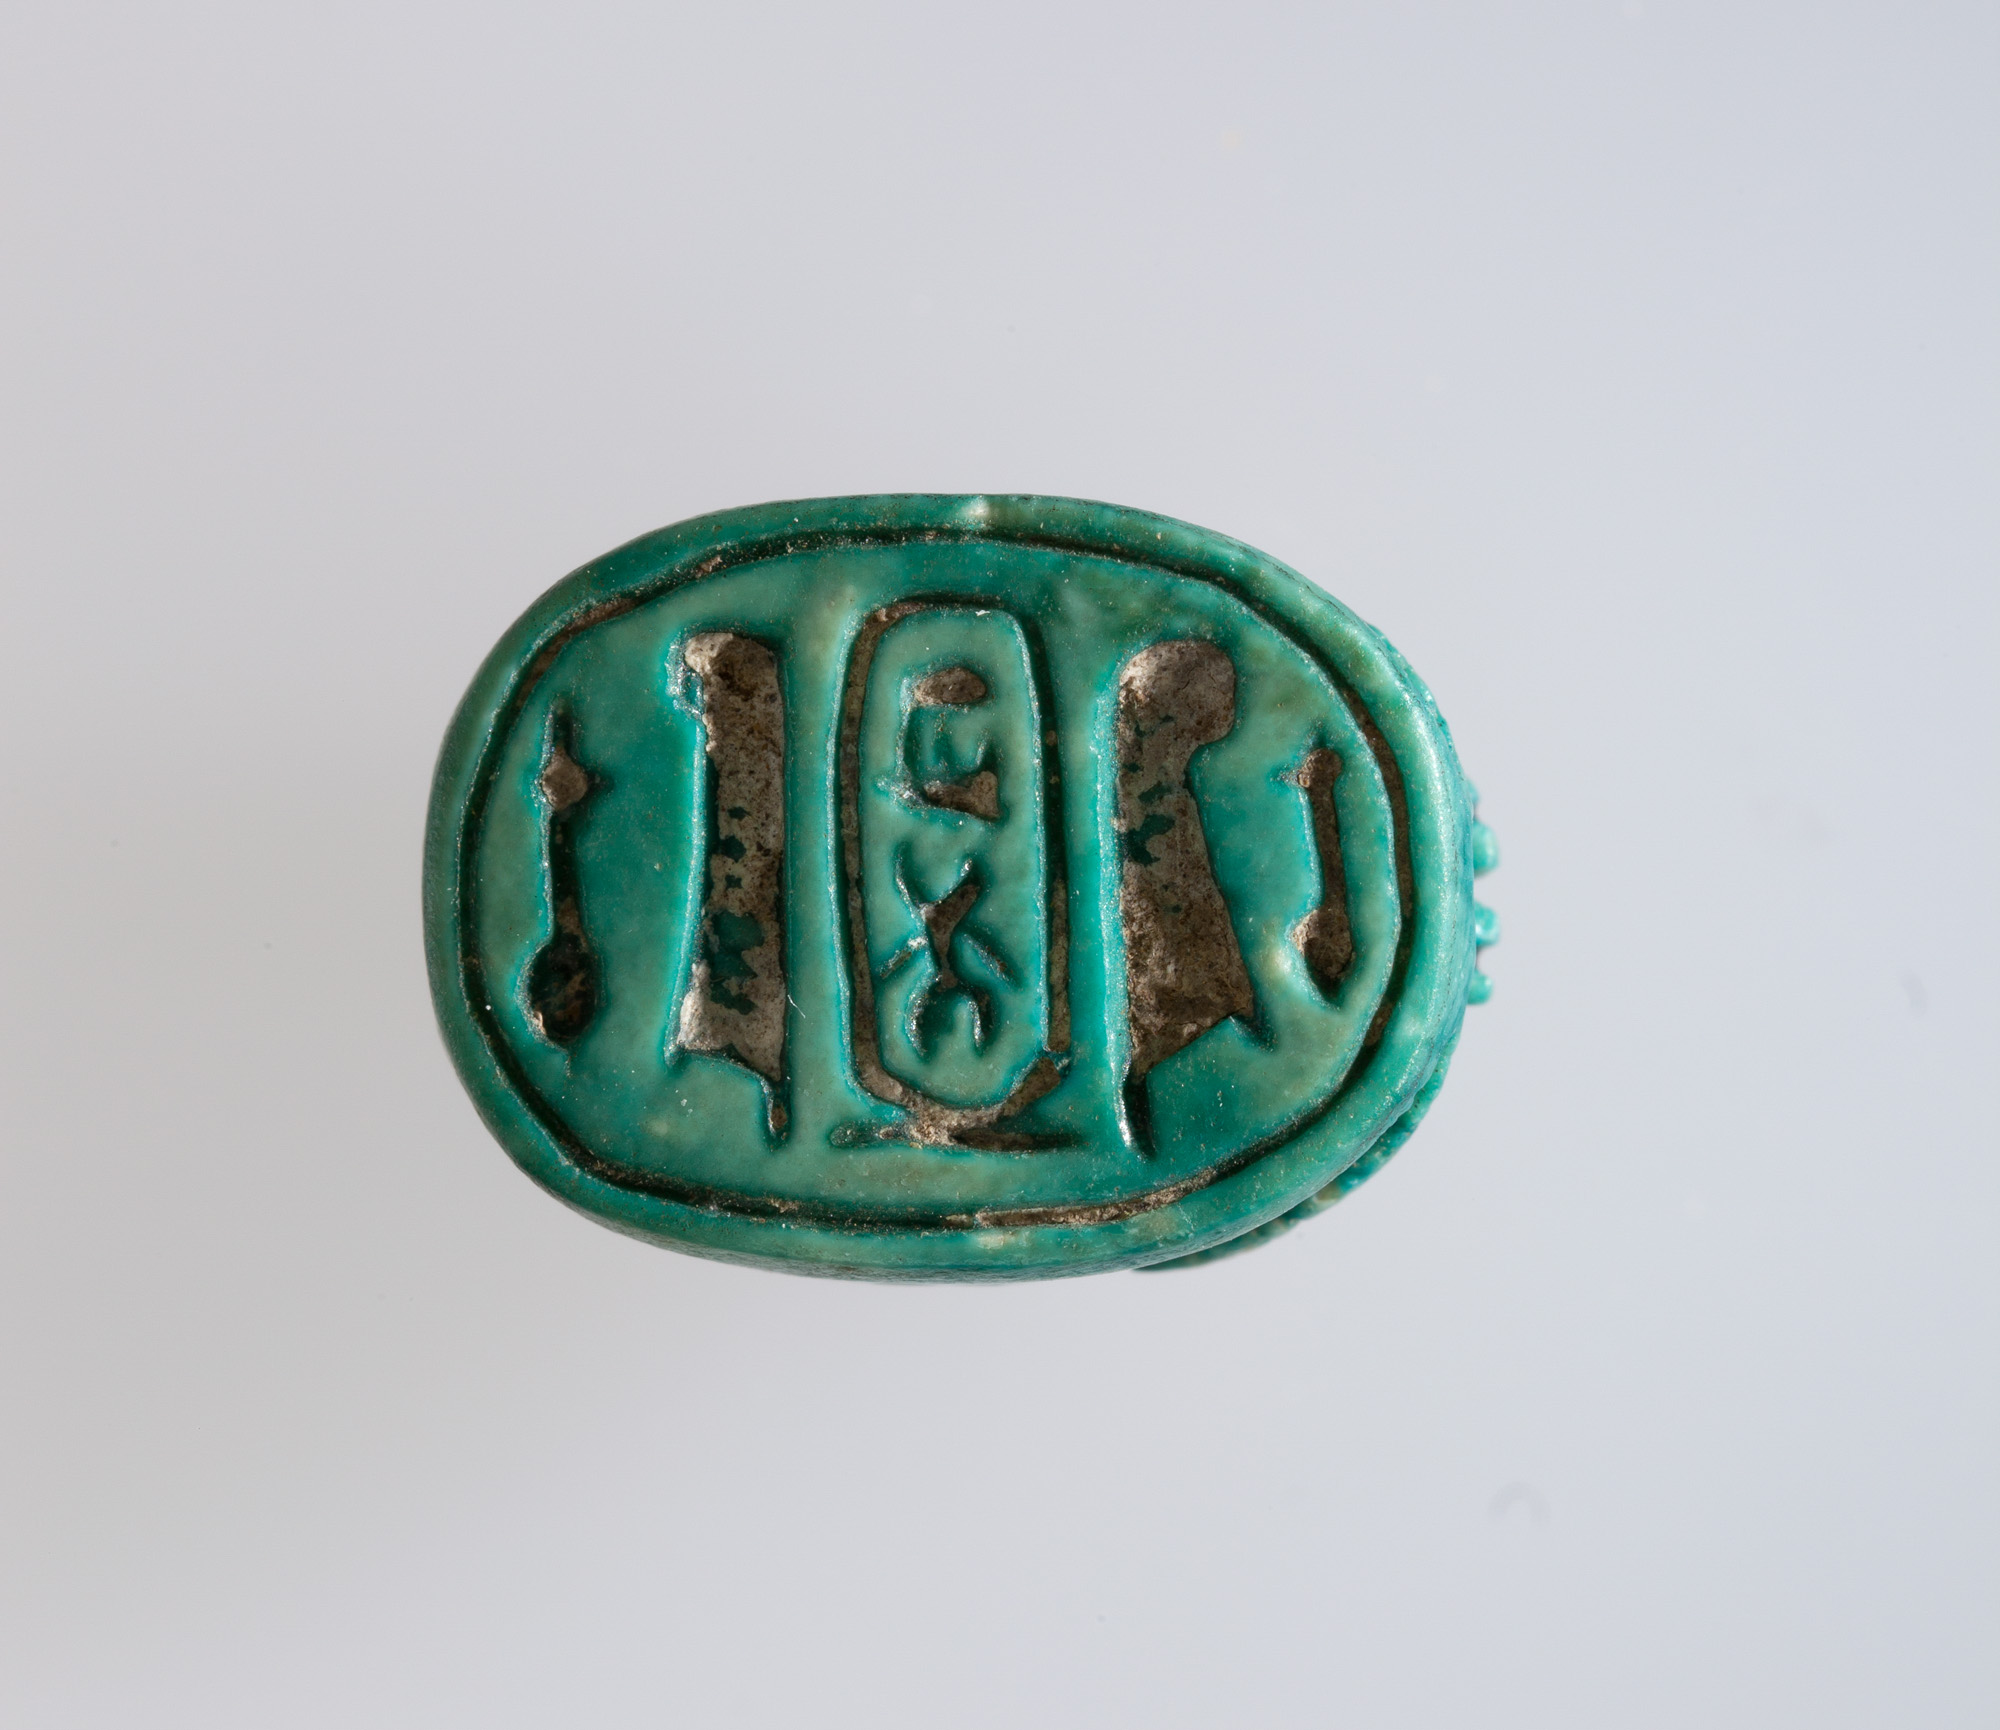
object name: scarab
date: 1479-1458 BCE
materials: stone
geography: egypt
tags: hieroglyphs,scarabs